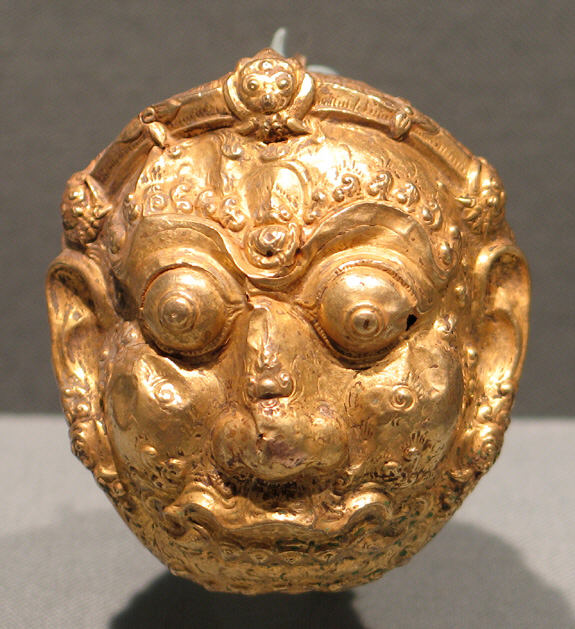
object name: rattle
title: Rattle with Kala Head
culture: indonesian, javanese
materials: gold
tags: faces,heads